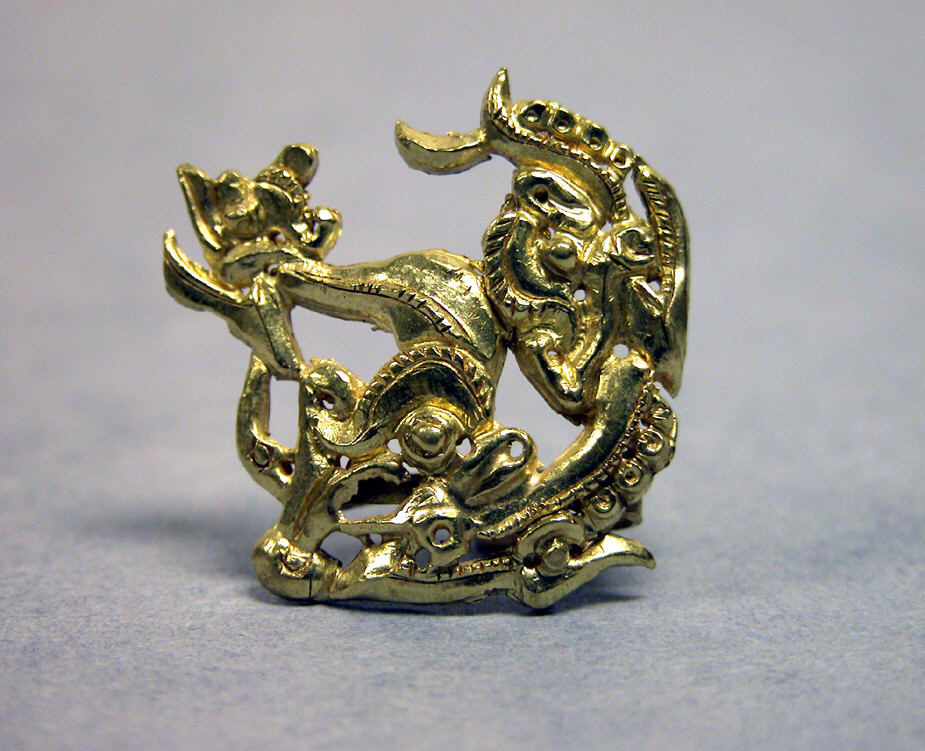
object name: ornament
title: Garuda with Dolphins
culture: indonesian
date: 1701-1800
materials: gold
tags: dolphins